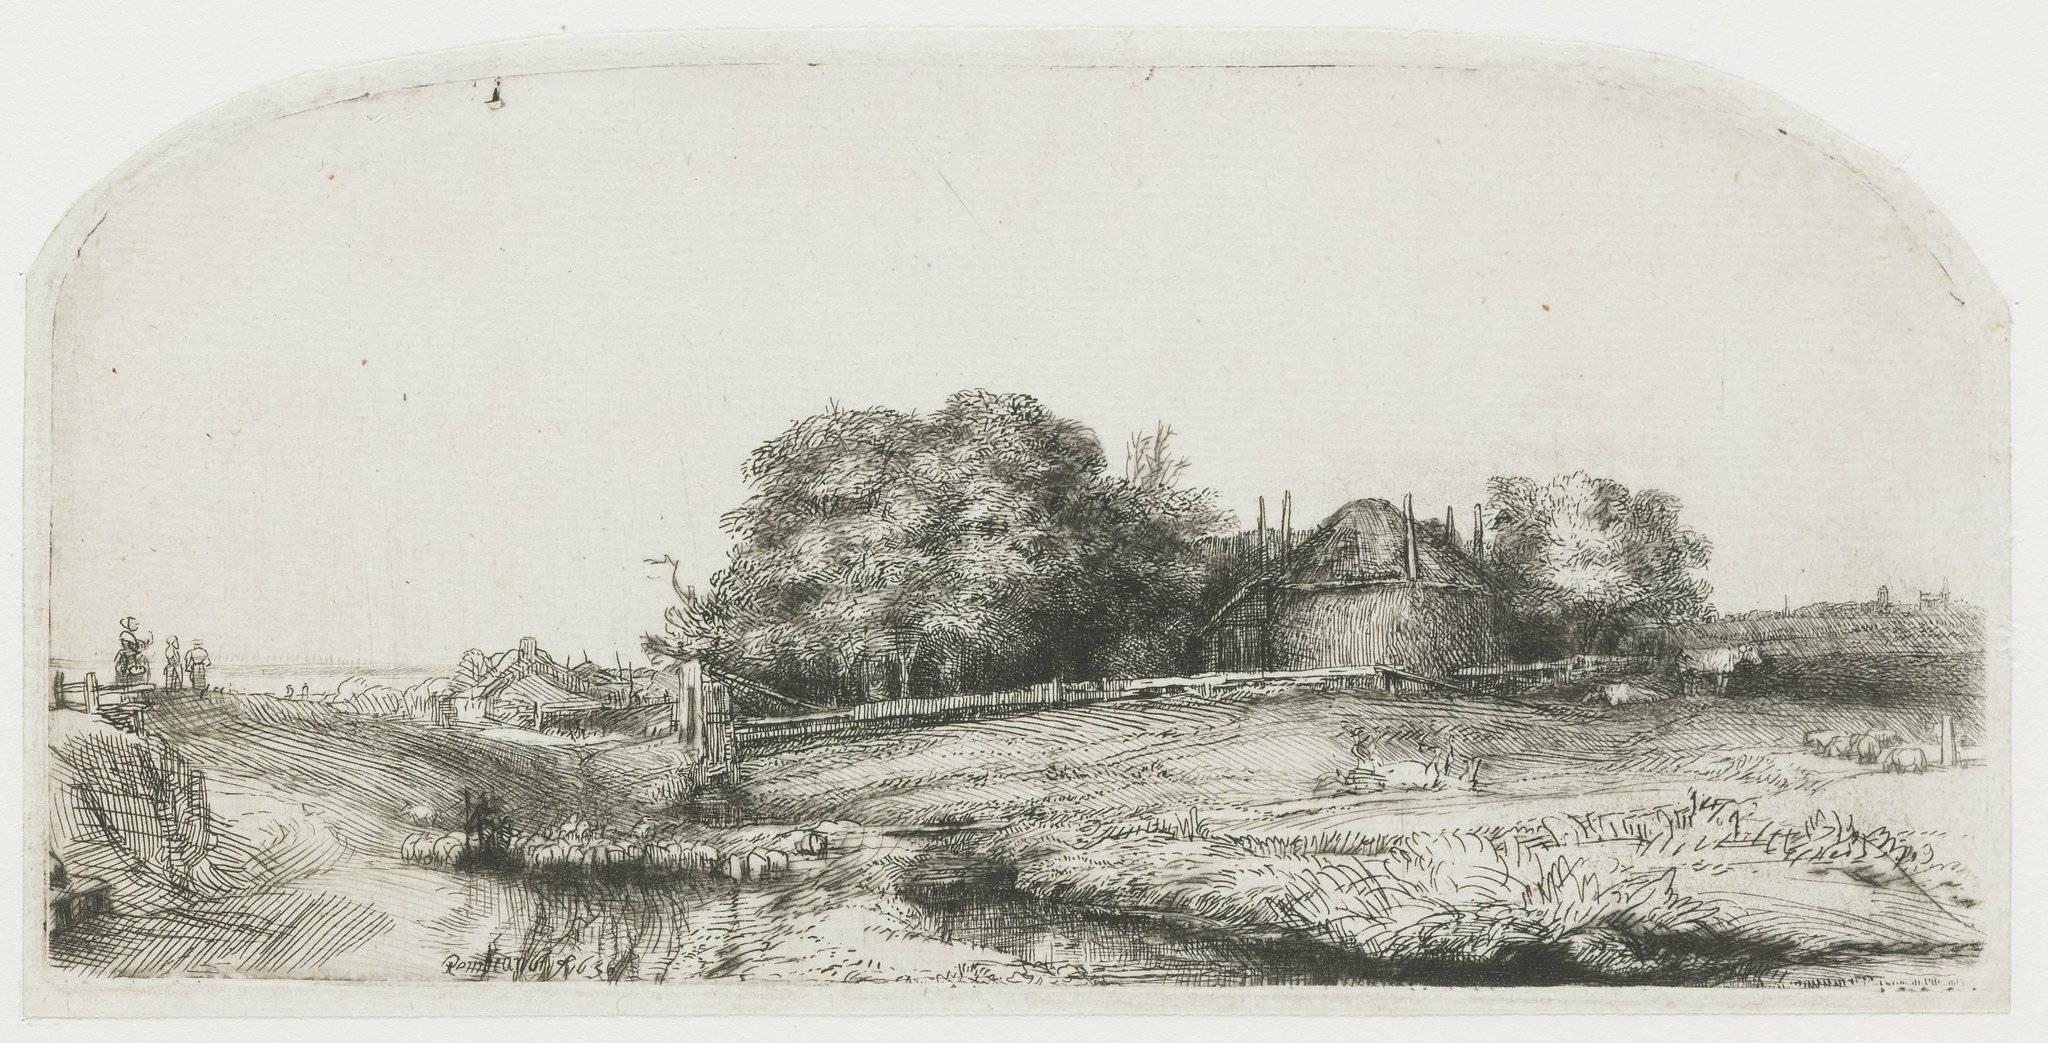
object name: print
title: Cottages and a hay barn on the Diemerdijk with a flock of sheep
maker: rembrandt van rijn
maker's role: draughtsman, painter, print maker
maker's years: 1606-1669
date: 1650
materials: paper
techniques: drypoint, etching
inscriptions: signature and date: ‘Rembrandt f 1652’, collector's mark: Lugt 2610, collector's mark: Lugt 2228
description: This is the same cottage on the Diemerdijk as in the etching on view above, here seen from the other side. In the distance at the far left, the masts of the ships in the harbour of Amsterdam can just be discerned. Rembrandt exhibits his eye for detail in the foreground as well: a horse rolls around in the meadow in front of the hay barn.